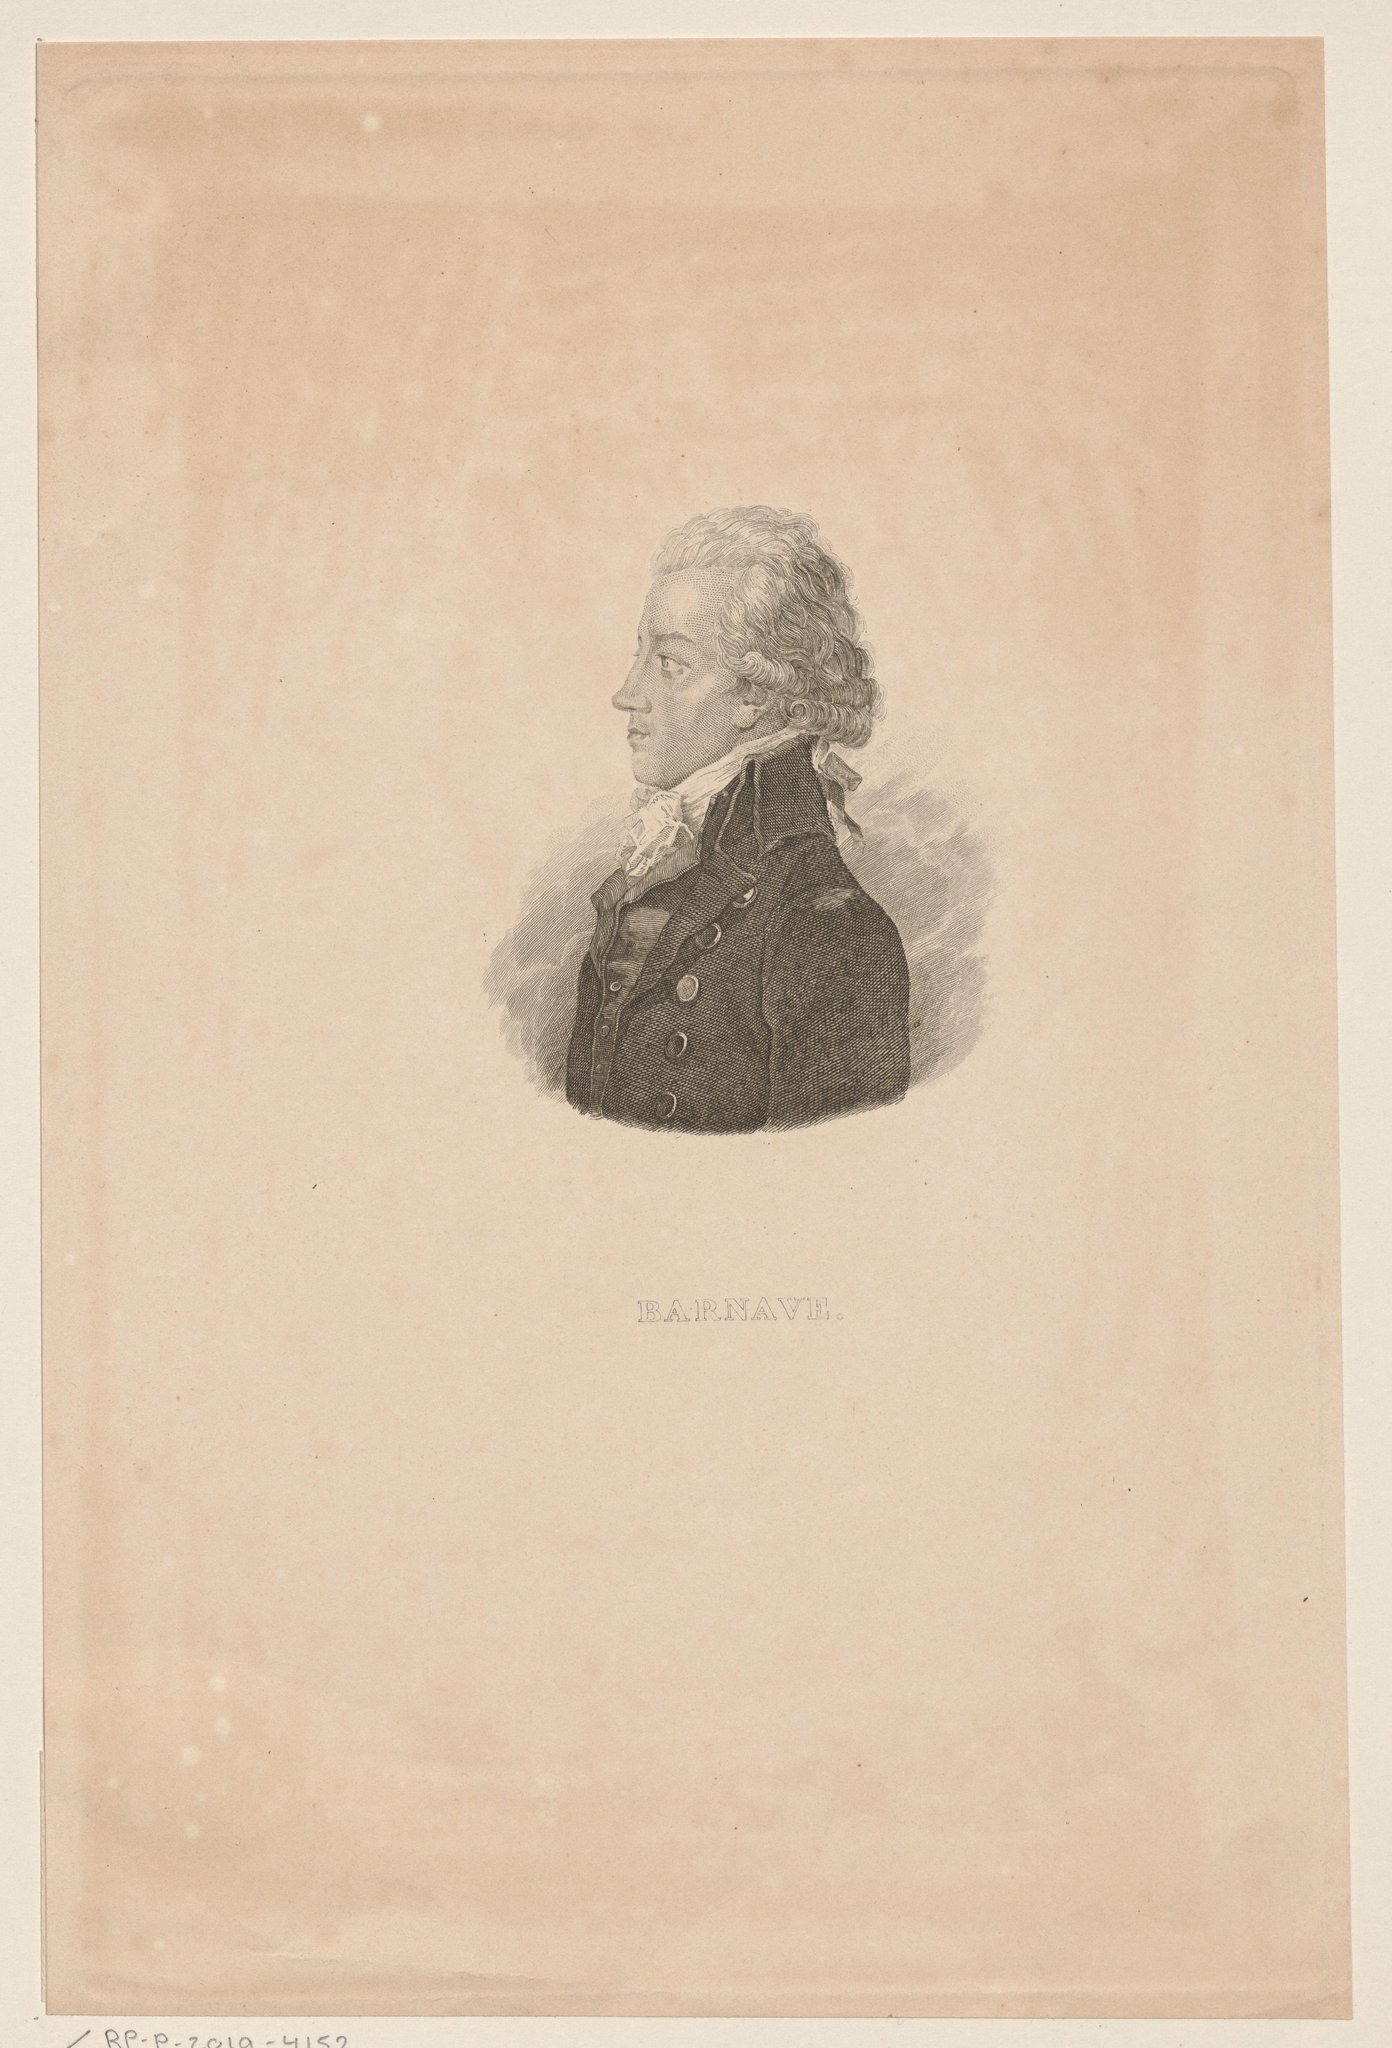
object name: print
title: Portret van Antoine-Pierre-Joseph-Marie Barnave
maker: Anonymous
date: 1780-1830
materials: paper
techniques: etching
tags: politician, historical persons